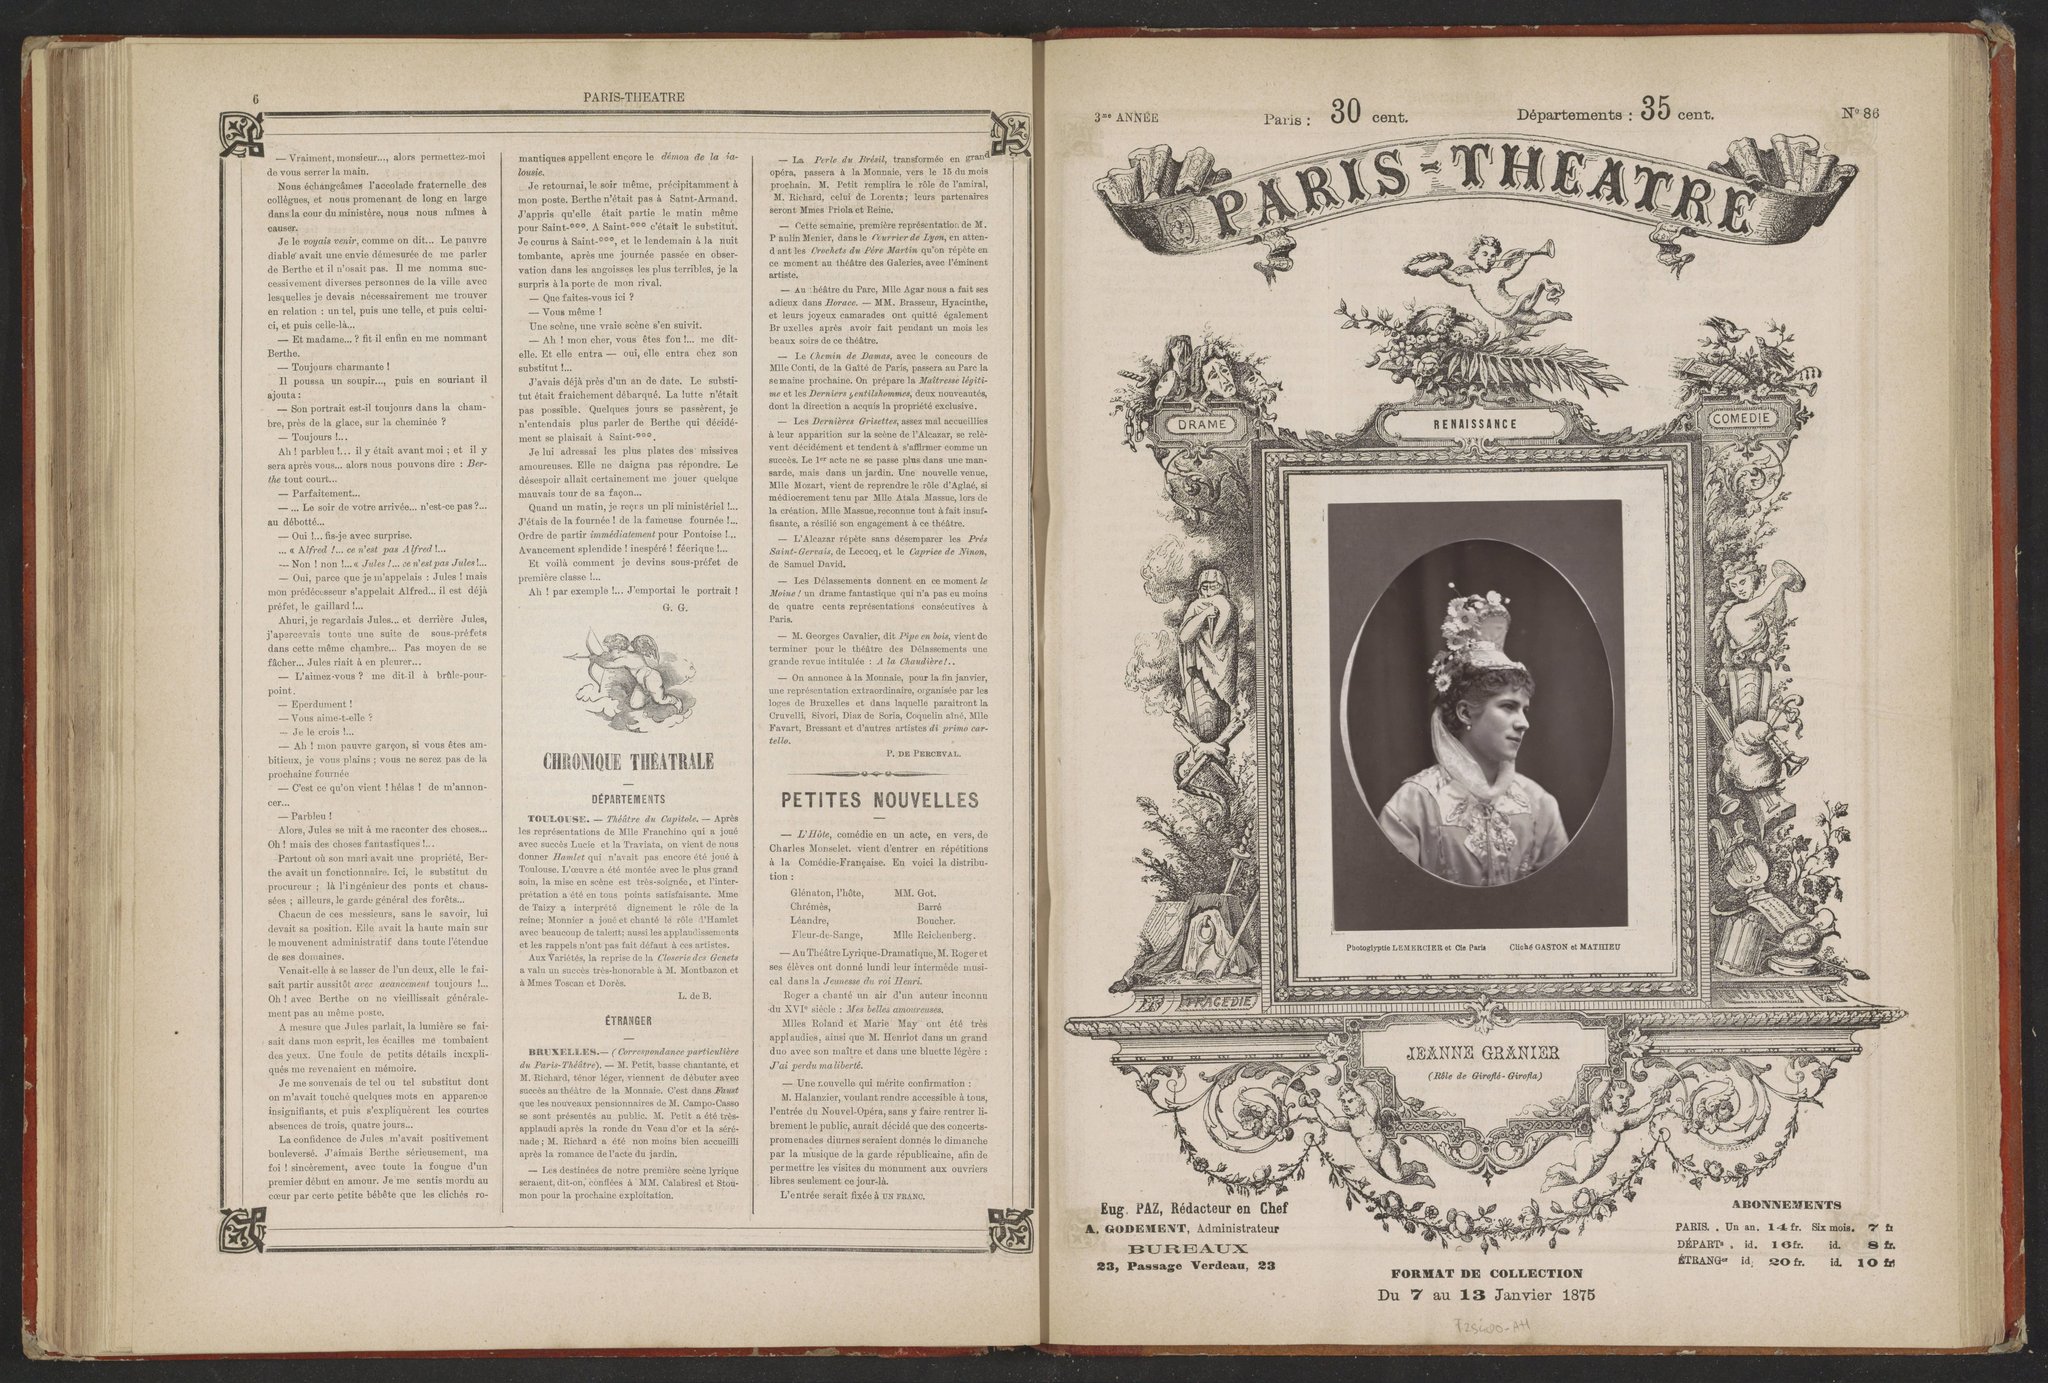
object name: photomechanical print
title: Jeanne Granier (Rôle de Giroflé-Girofla)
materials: paper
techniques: woodburytype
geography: france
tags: portrait of opera-singer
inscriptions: inscription: ‘Journal hebdomadaire paraissant le jeudi Du 7 au 13 Janvier 1875’, number: ‘No 86’